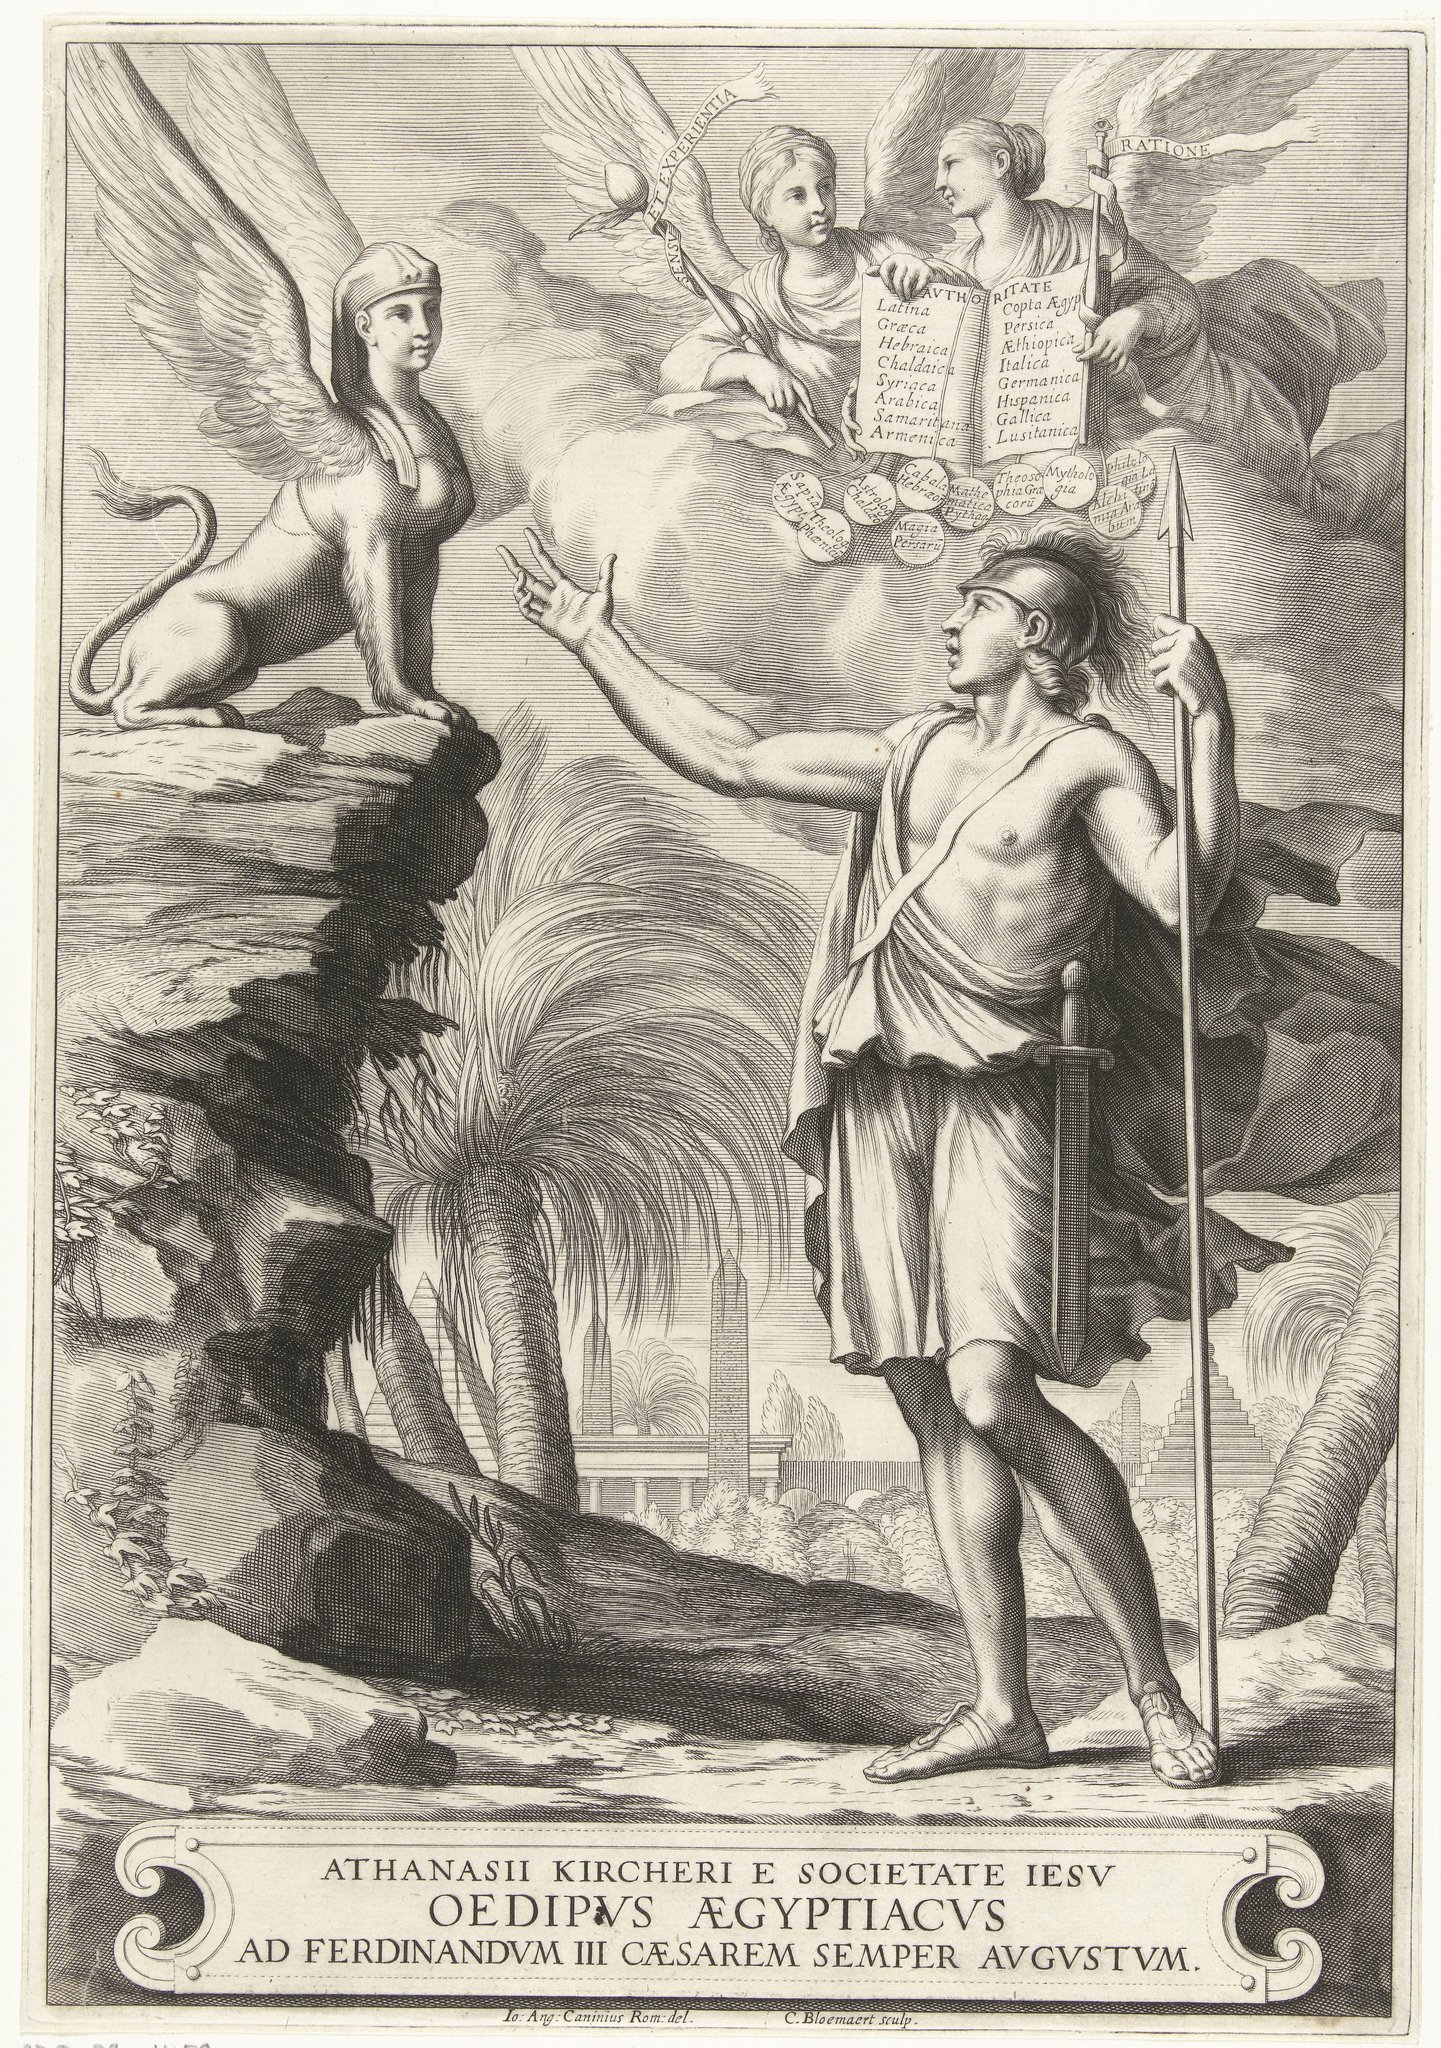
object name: print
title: Titelpagina voor A. Kircher, Oedipus Aegyptiacus, Rome: 1652-1654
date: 1652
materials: paper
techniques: engraving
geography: rome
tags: rome, oedipus and the sphinx; he solves the riddle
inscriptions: collector's mark: Lugt 240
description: Oedipus, koning van Thebe, staat tegenover de sfinx, een monster met het hoofd en borsten van een vrouw, het lichaam van een leeuw, de staart van een slang en de vleugels van een adelaar. Elke langskomende reiziger wordt door het monster ondervraagd. Wie het antwoord niet weet, wordt verscheurd. Oedipus vernietigt de sfinx door het juiste antwoord te geven.